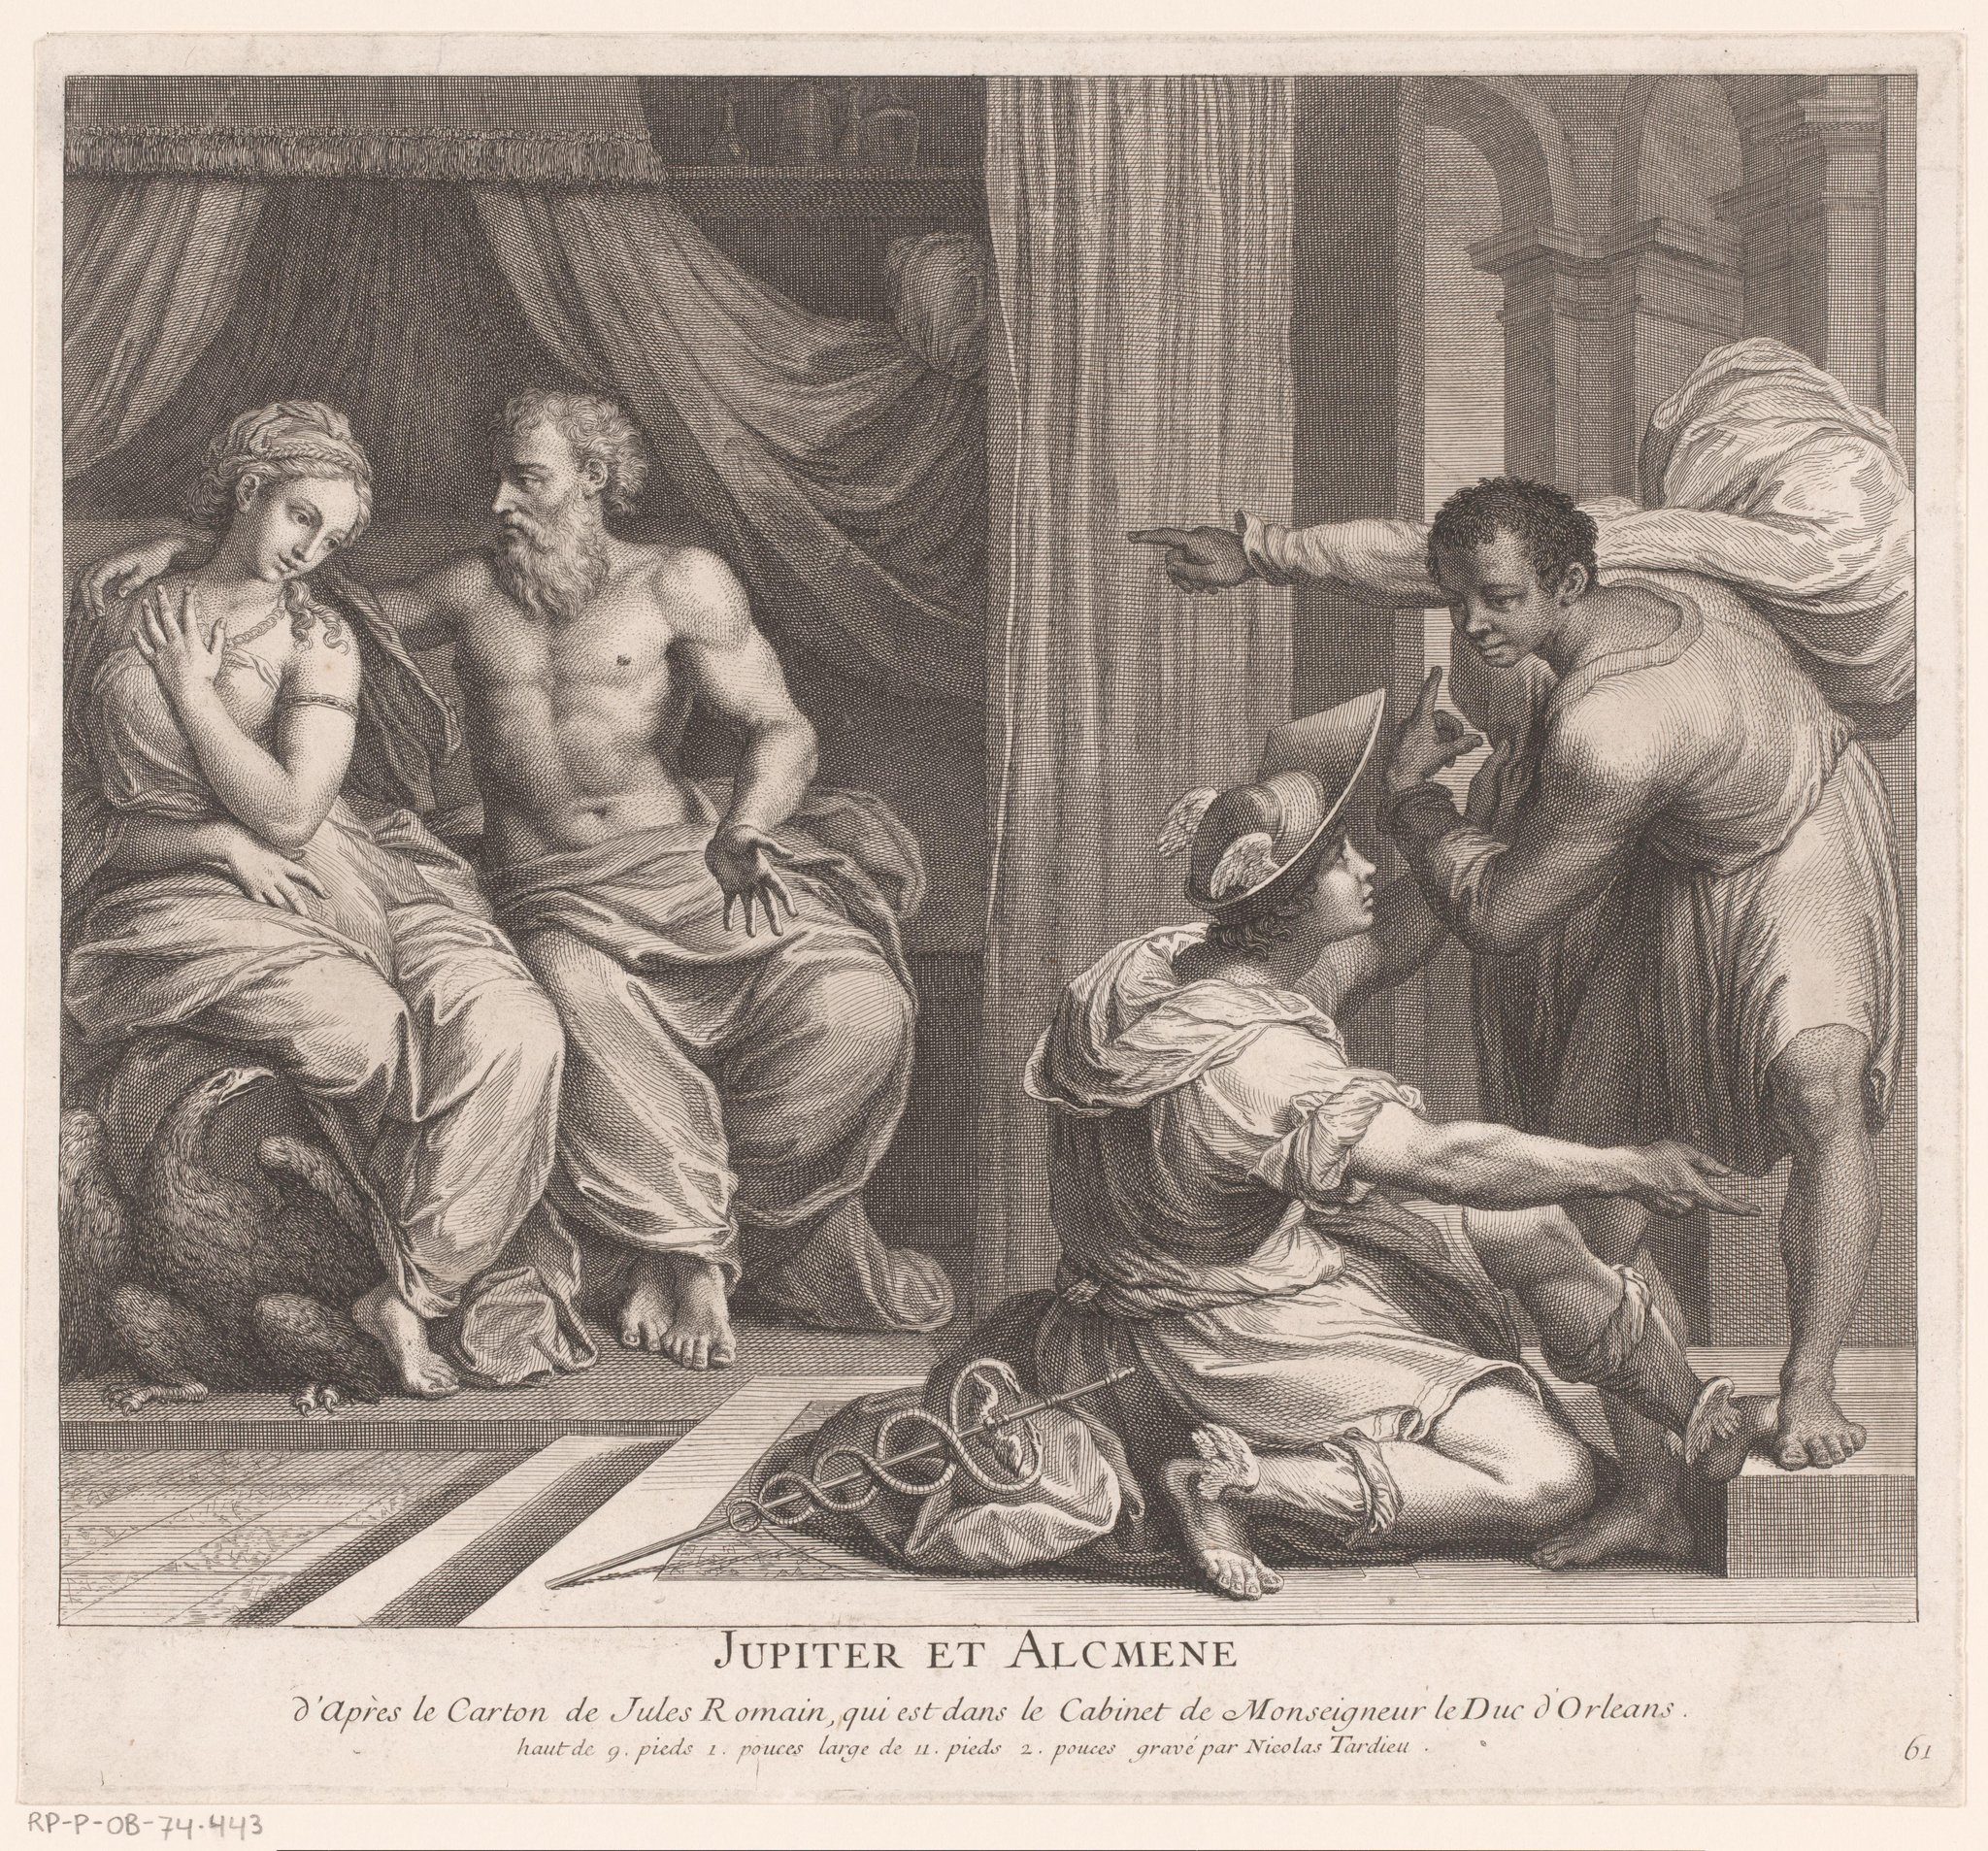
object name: print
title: Jupiter en Alcmene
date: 1684-1749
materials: paper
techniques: engraving, etching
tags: (story of) mercury (hermes) - apotheosis, deification, jupiter, in the guise of amphitryon, and alcmene, mother of hercules, manservant, footman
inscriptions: collector's mark: Lugt 2228